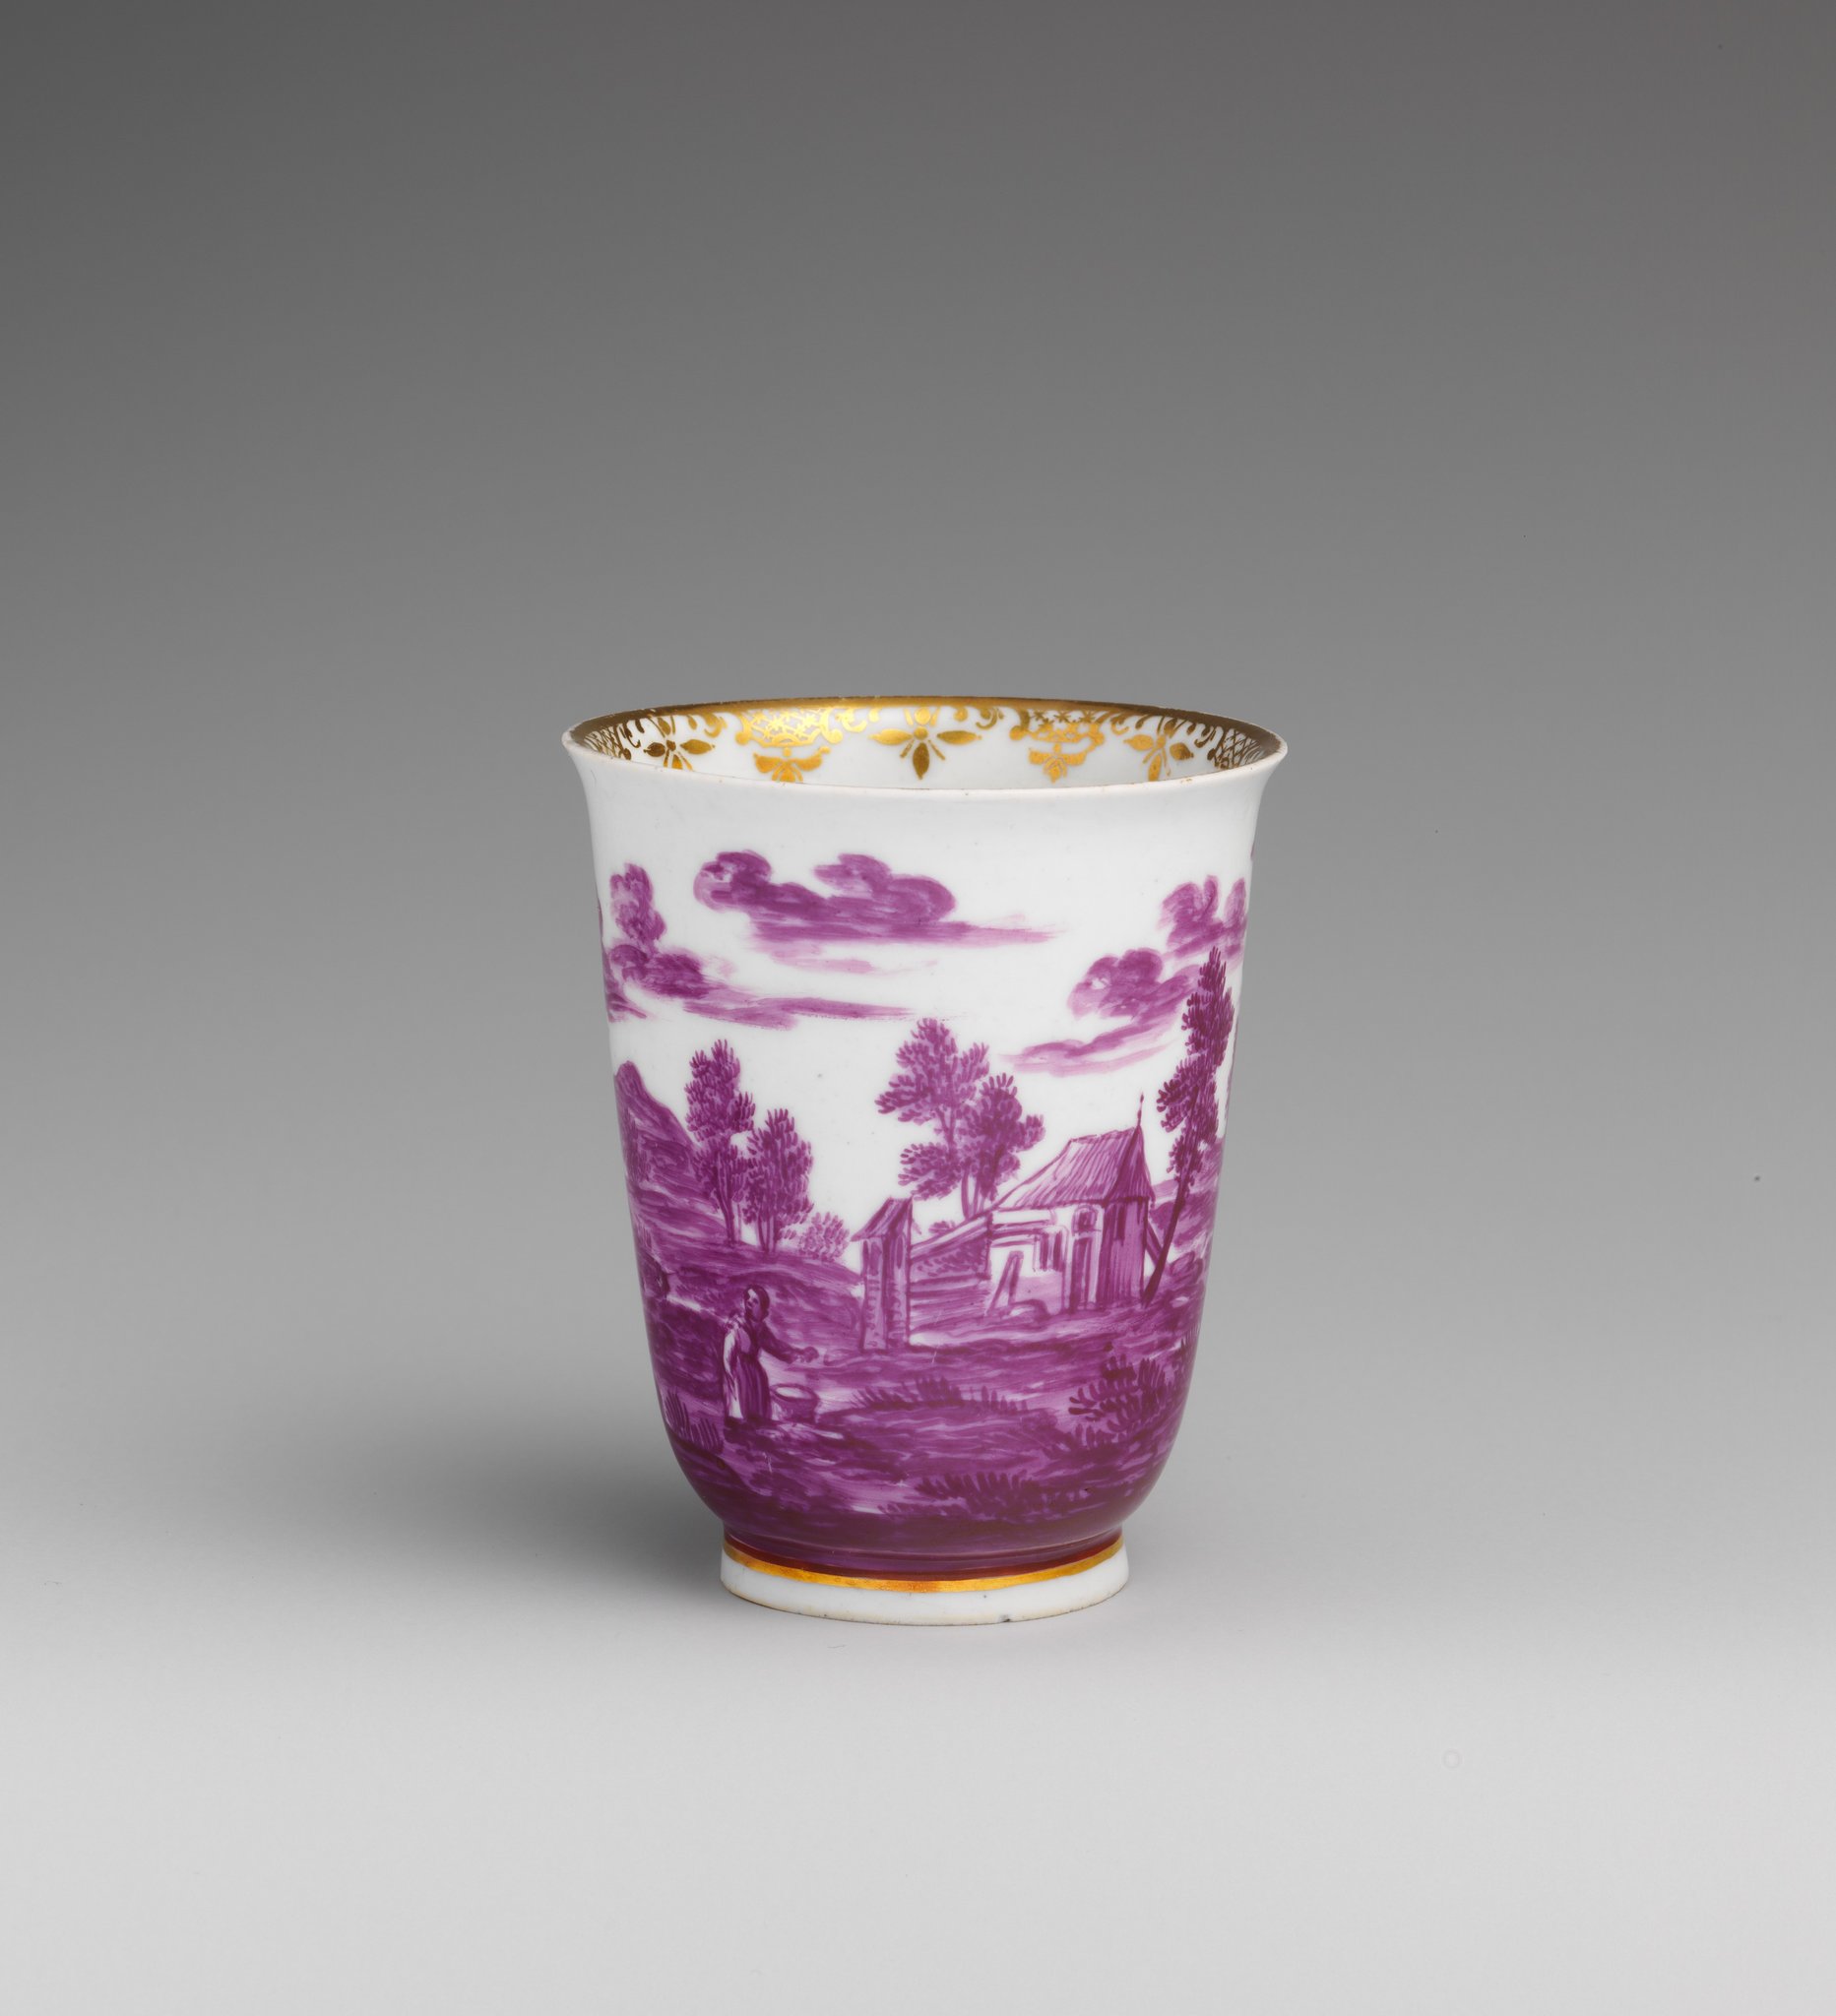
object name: cup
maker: possibly claudius innocentius du paquier period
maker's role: factory director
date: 1735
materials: hard paste porcelain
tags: landscapes